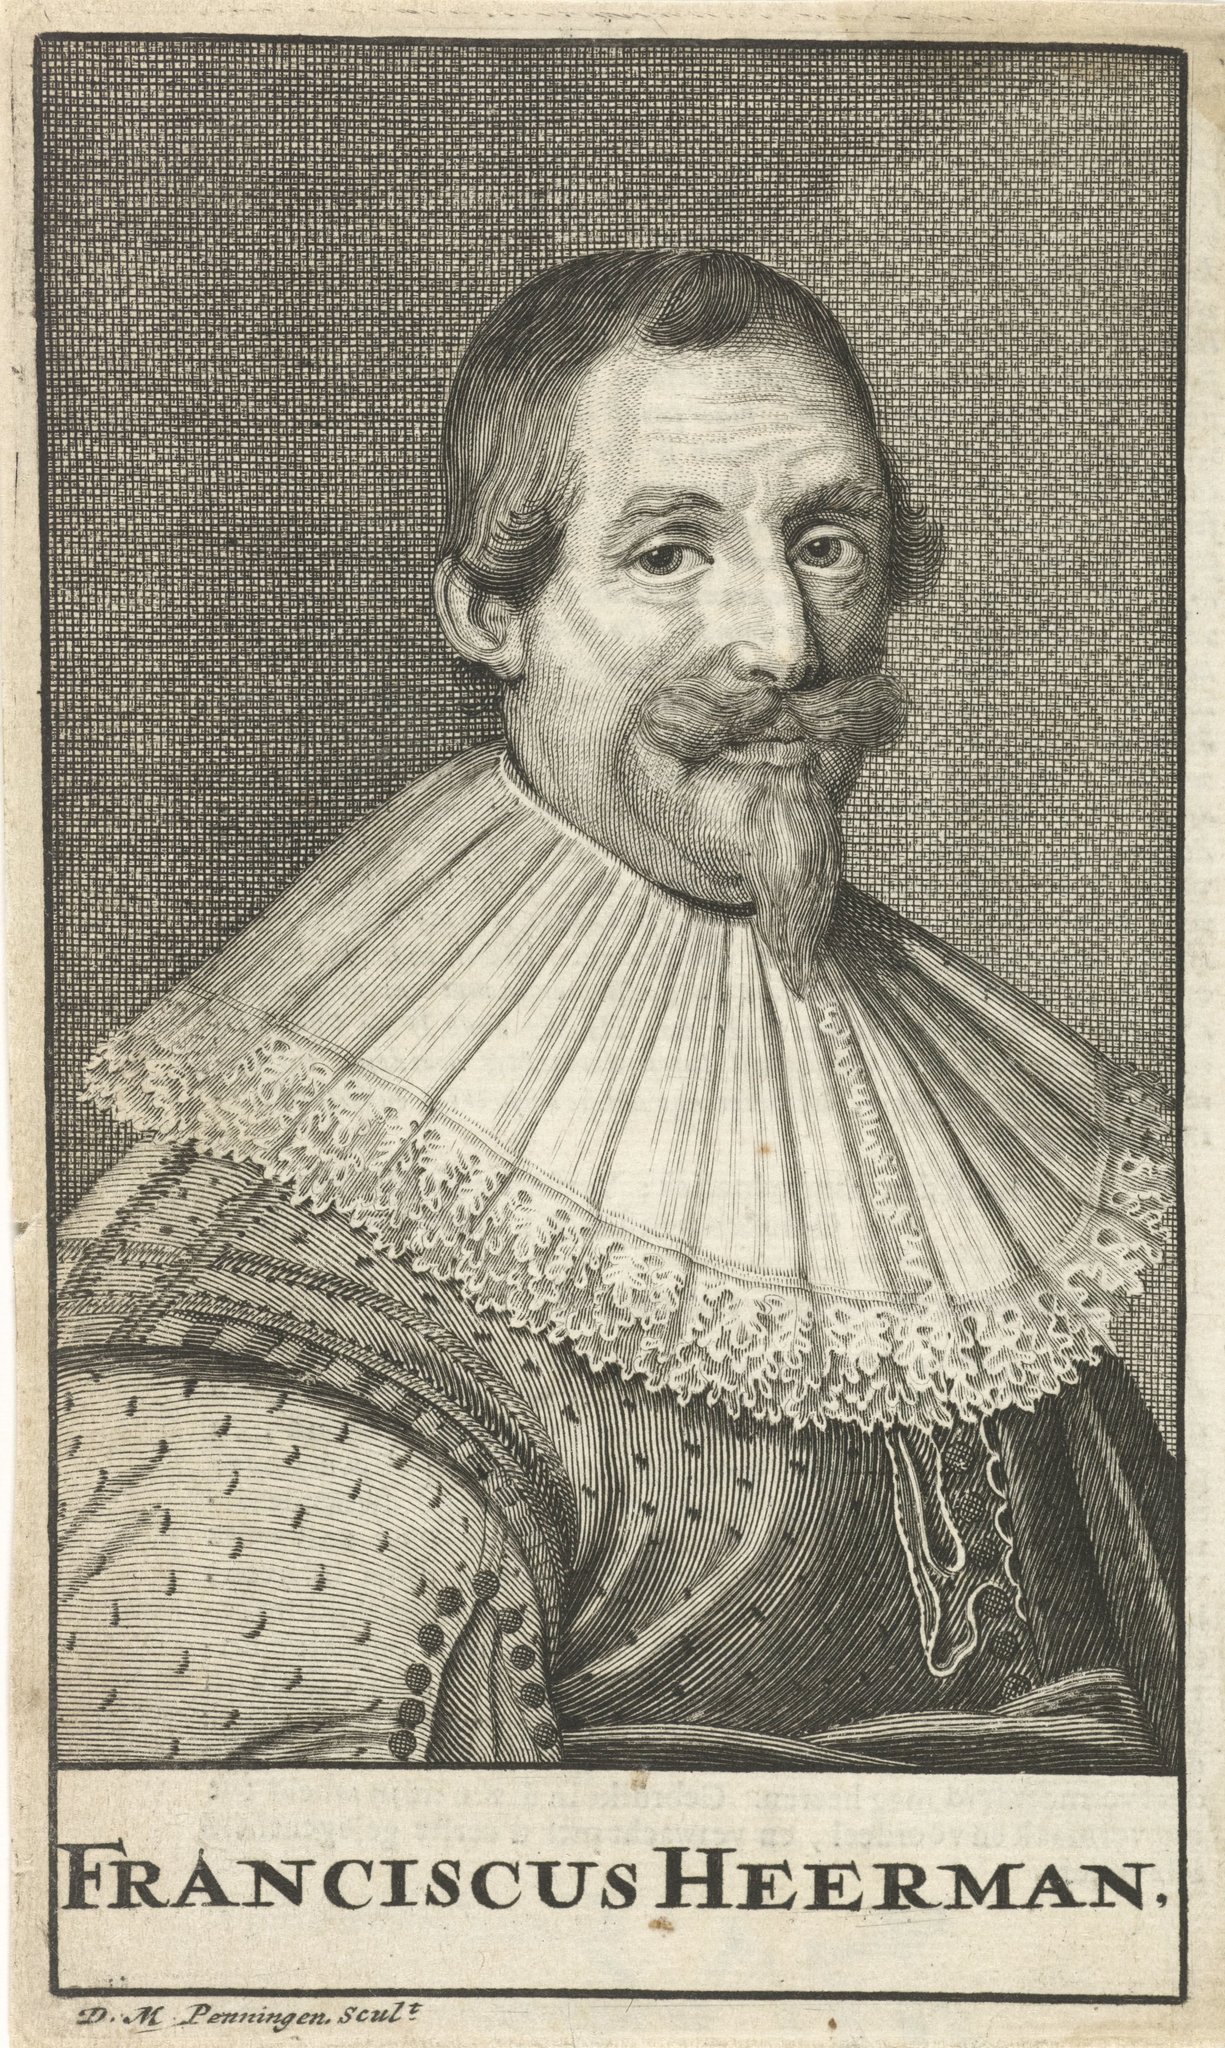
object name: print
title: Portret van de schrijver Franciscus Heerman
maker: daniël met de penningen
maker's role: print maker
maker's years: -1696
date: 1699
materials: paper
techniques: engraving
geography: amsterdam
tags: neck-gear: collar (+ men's clothes)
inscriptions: collector's mark: Lugt 2228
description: Prent uit: Heerman, Franciscus, Guldene annotatien. Amsterdam: J. ten Hoorn, 1699.